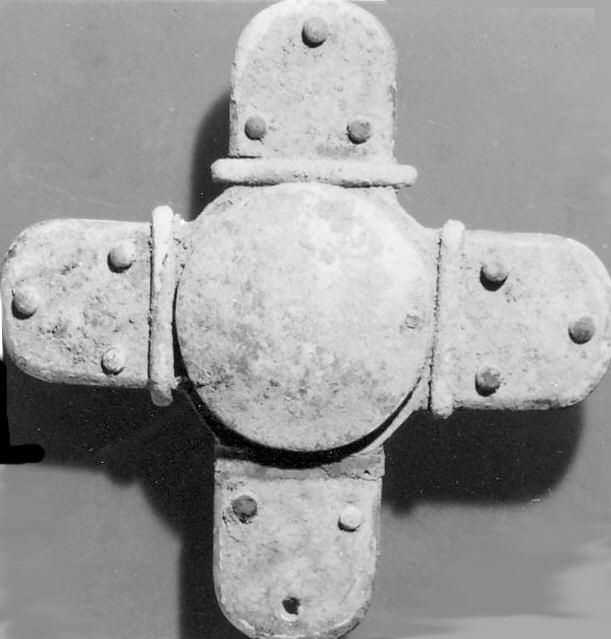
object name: harness and strap buckle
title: Harness and strap buckles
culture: japanese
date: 200-538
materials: gilt bronze